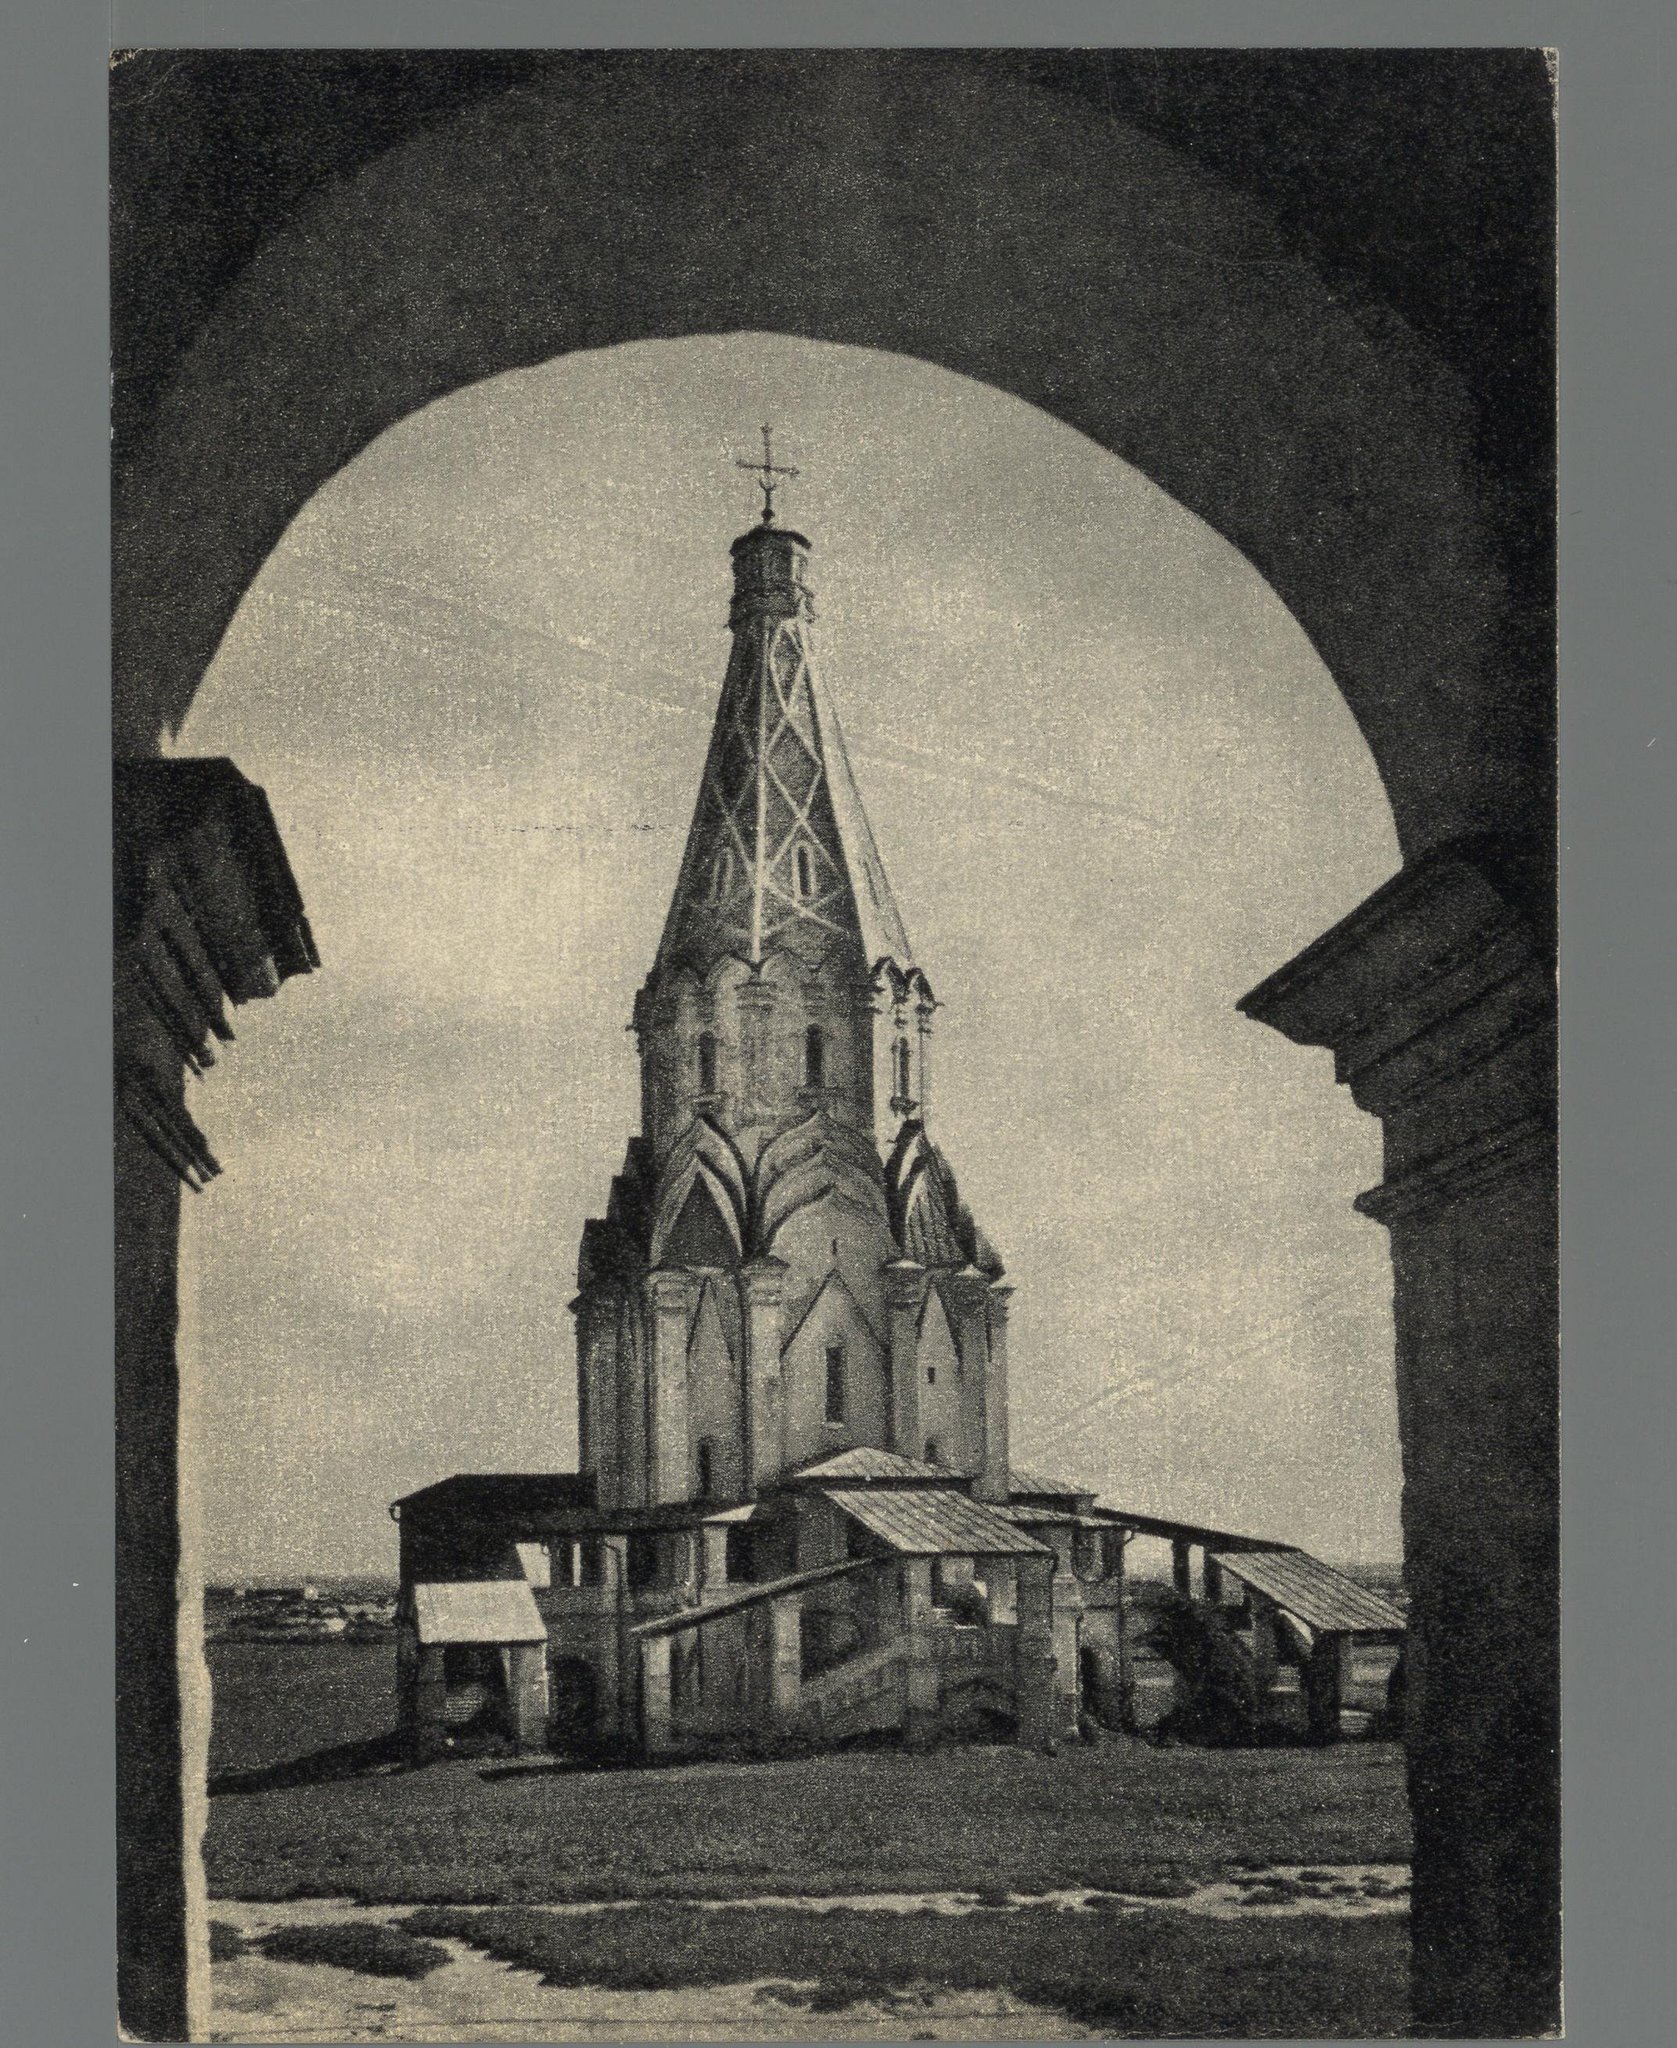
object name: photomechanical print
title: Gezicht op de Kerk van de Hemelvaart te Kolomenskoje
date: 1957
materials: cardboard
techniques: rotogravure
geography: moscow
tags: church (exterior)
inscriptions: date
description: De titel op object staat in het Russisch.